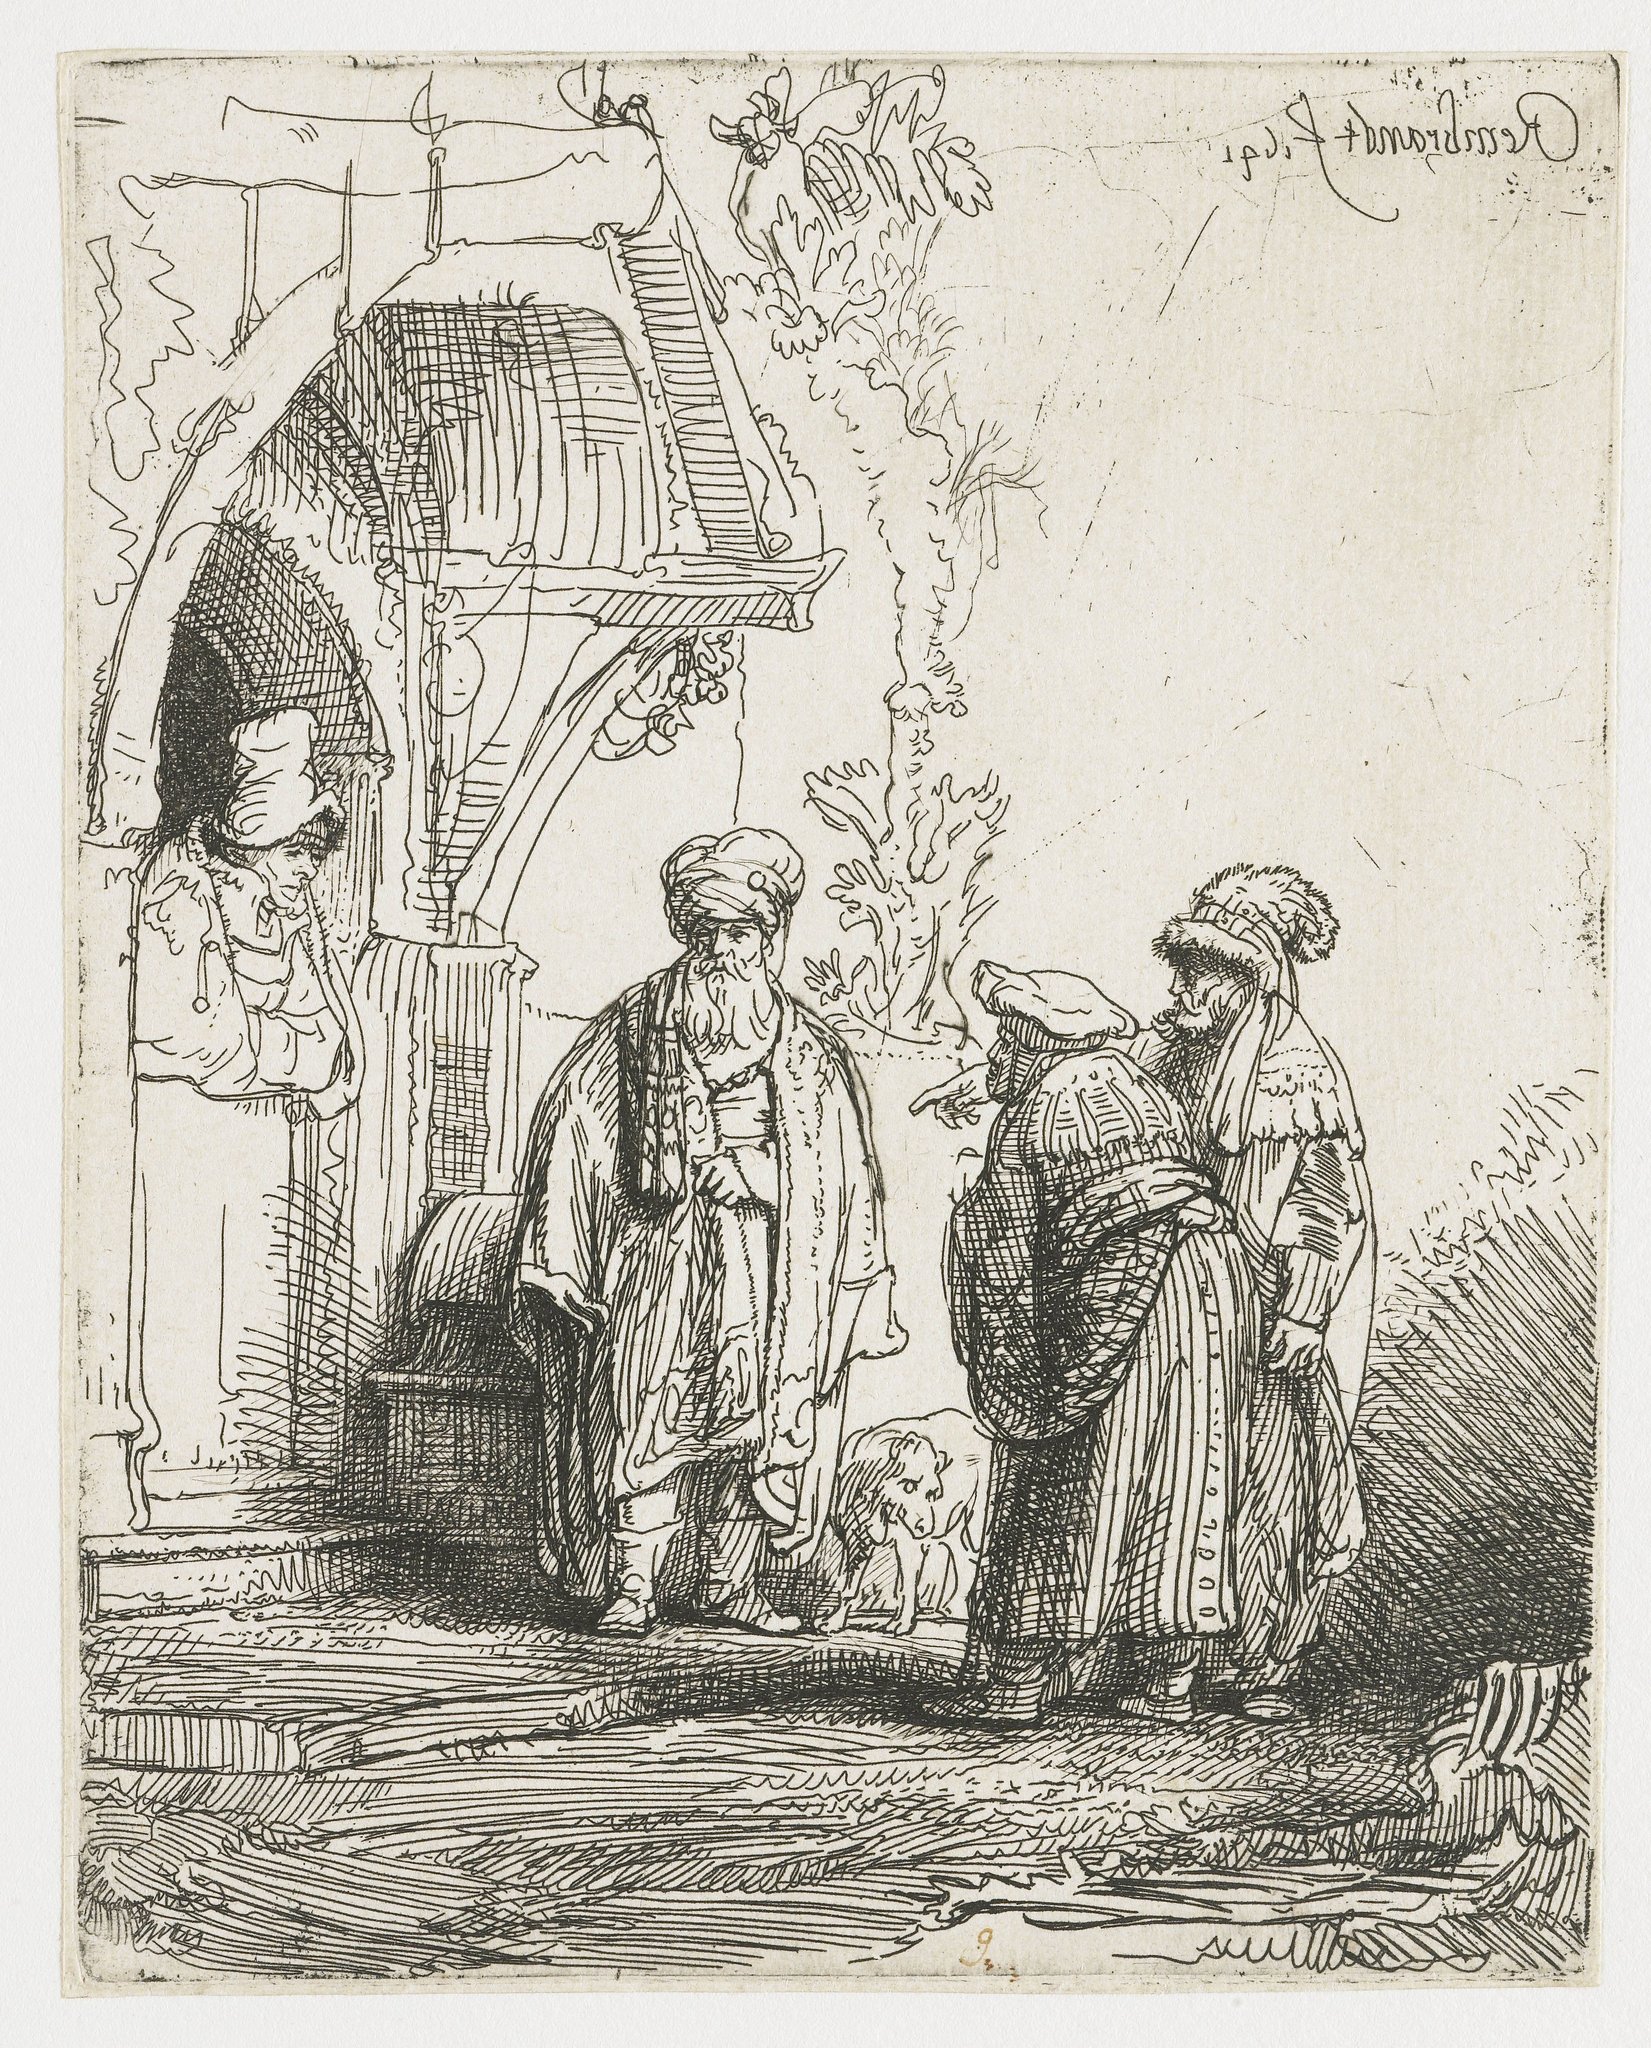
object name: print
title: Three oriental figures (Jacob and Laban?)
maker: rembrandt van rijn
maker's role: draughtsman, painter, print maker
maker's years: 1606-1669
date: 1641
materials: paper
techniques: drypoint, etching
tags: the partnership with laban ~ story of jacob (genesis 30:25-43)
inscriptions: signature and date: ‘Rembrandt f 1641 (spiegelbeeldig)’, collector's mark: Lugt 240